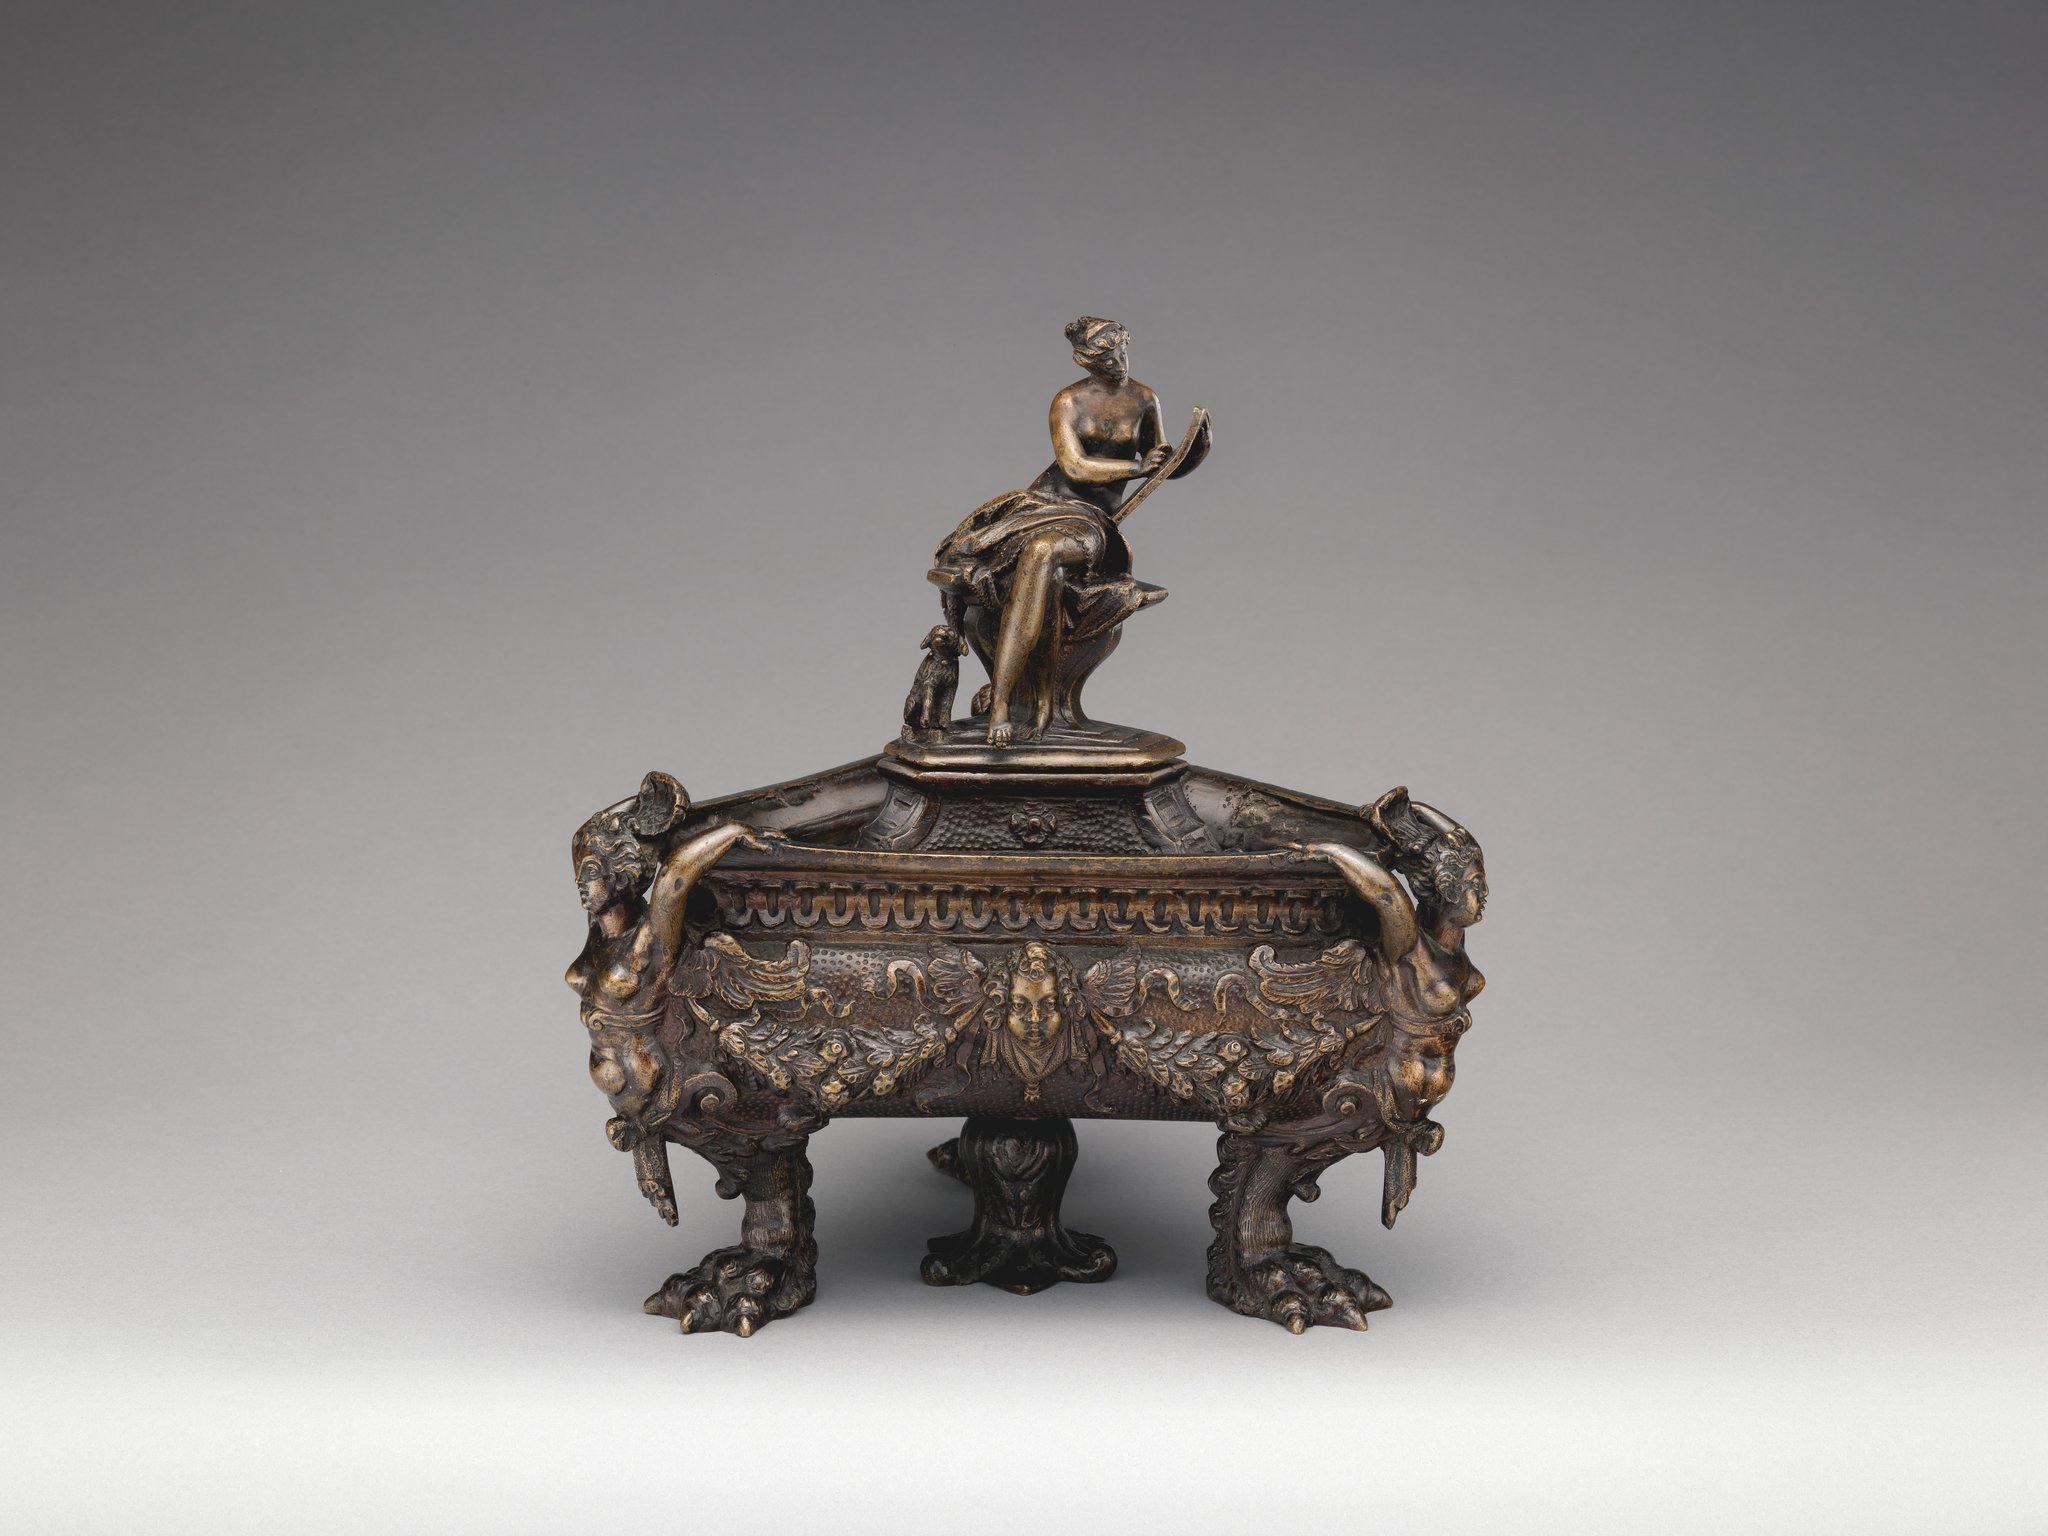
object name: inkstand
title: Inkwell (one of a pair) surmounted by finial figure representing History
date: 1601-1700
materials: bronze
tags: eagles,female nudes,allegory